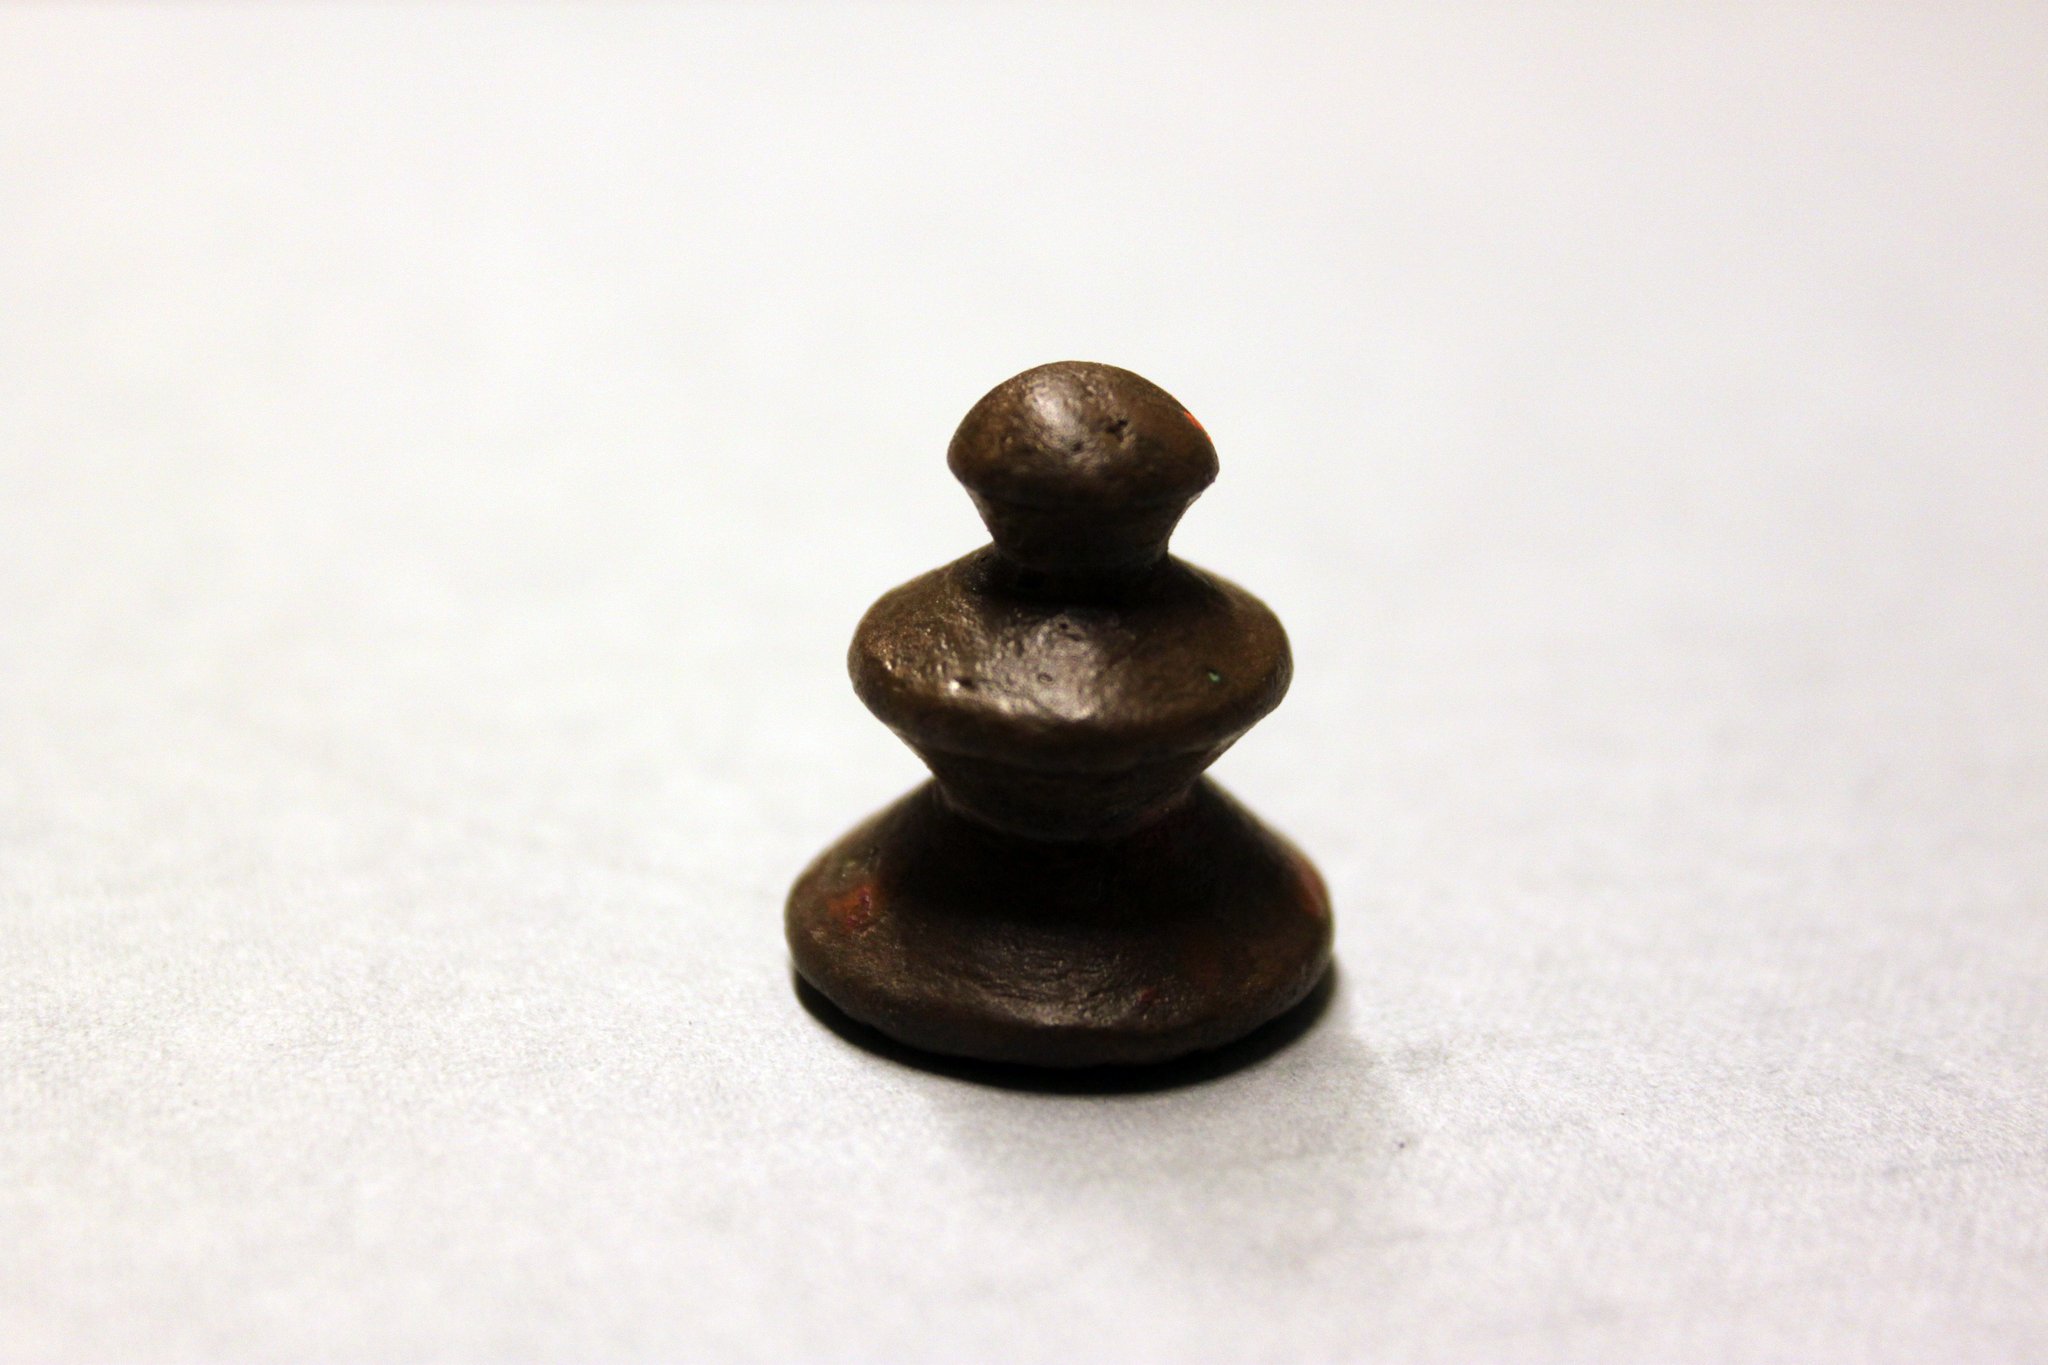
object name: seal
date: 801-1100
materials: bronze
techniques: casting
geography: iran